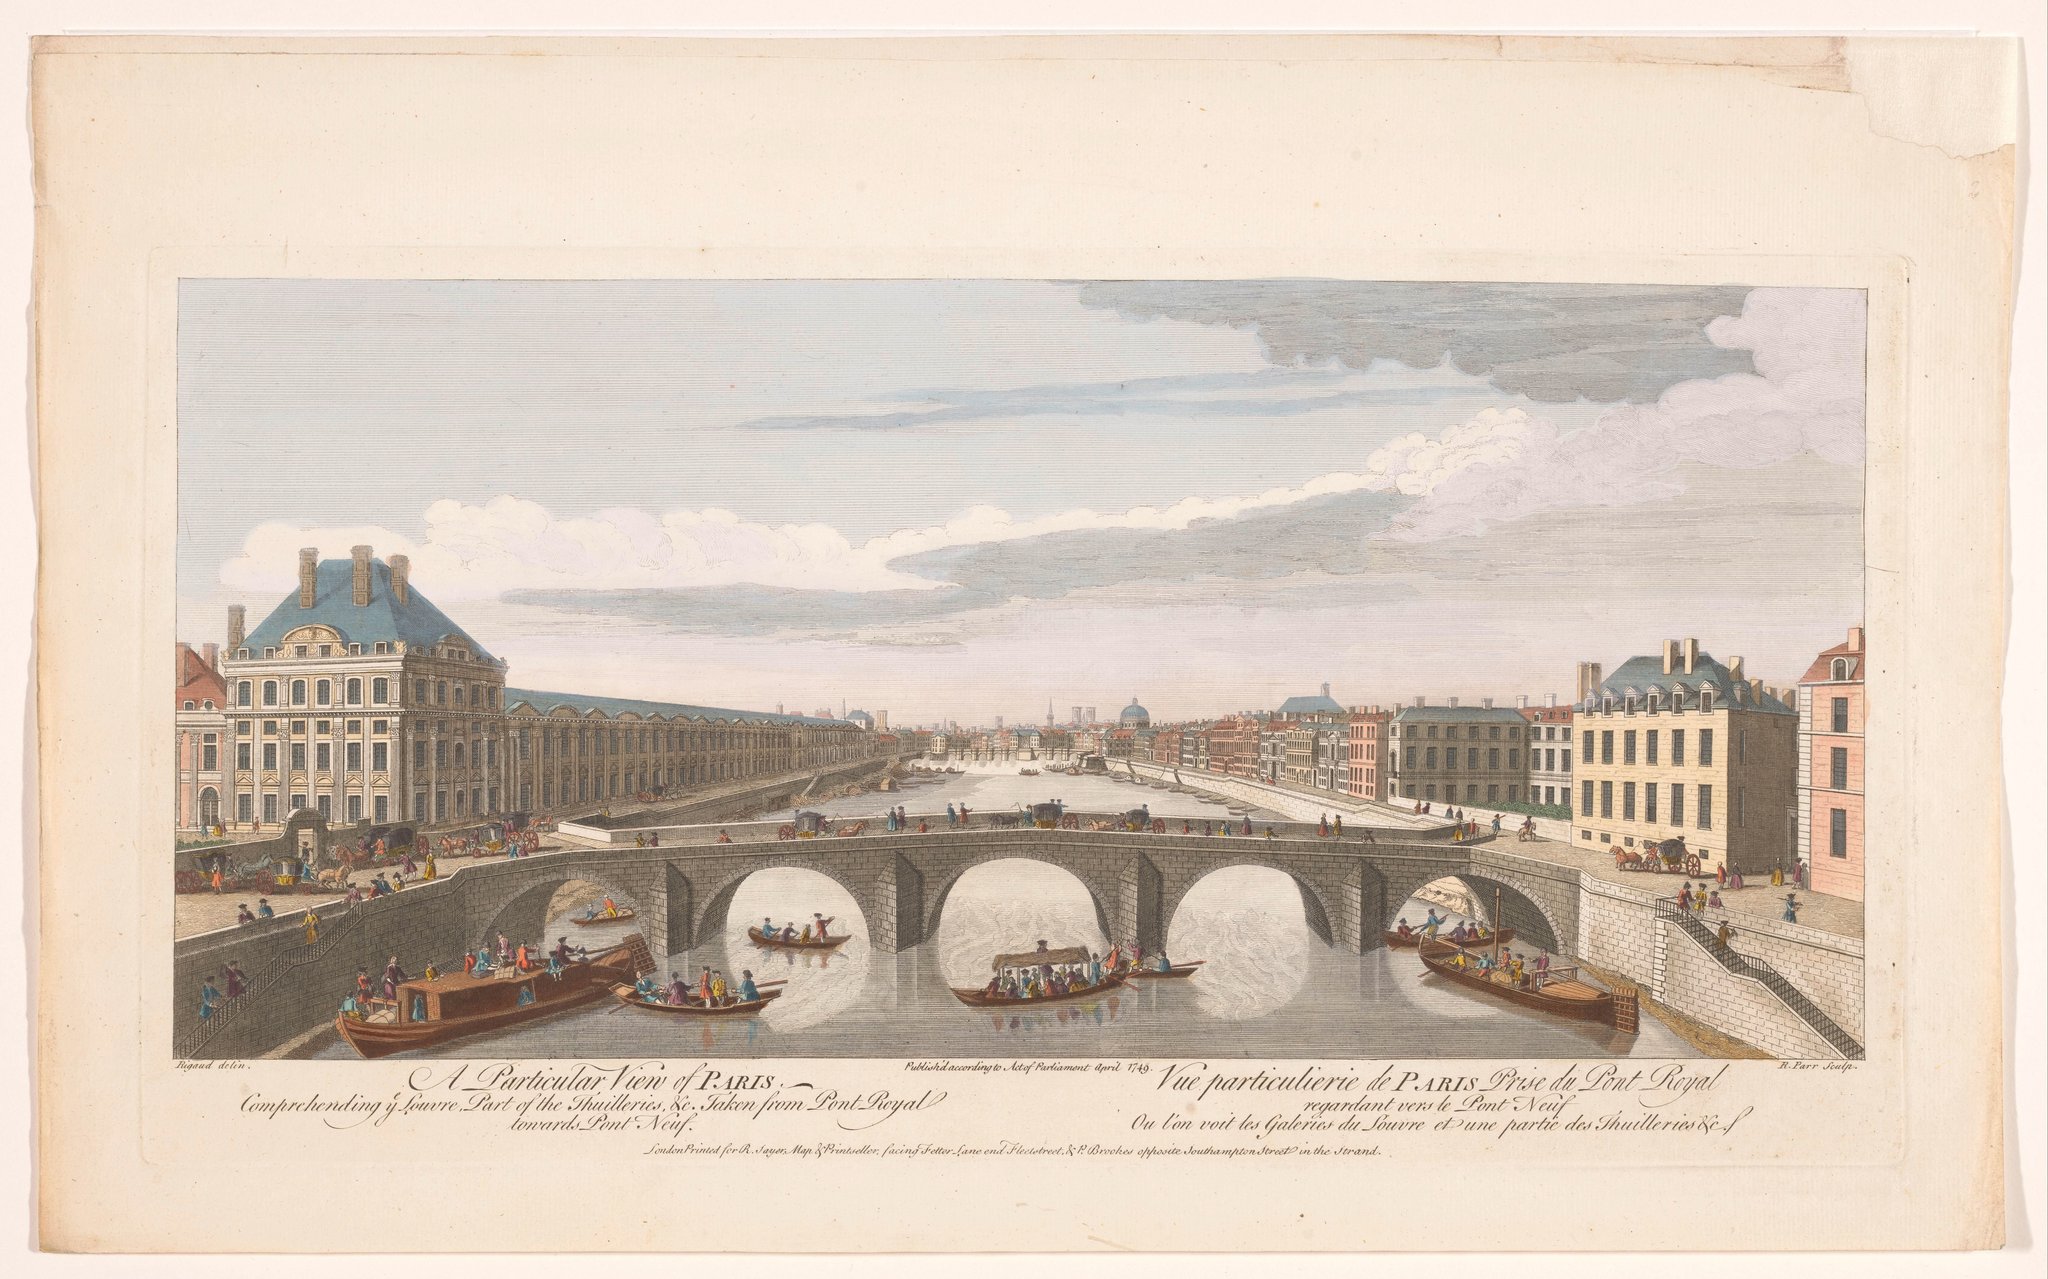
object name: print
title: Gezicht op de Pont Royal over de rivier de Seine te Parijs, gezien richting de Pont Neuf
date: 1704-1749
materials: paper, watercolor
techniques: brush, etching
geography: london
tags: bridge in city across river, canal, etc. (+ city(-scape) with figures, staffage), palace, rowing-boat, canoe, etc., tuileries palace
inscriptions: watermark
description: De serie “Parijs” bevat zes prenten met de nummers 1-6, waarvan dit nummer 2 is.